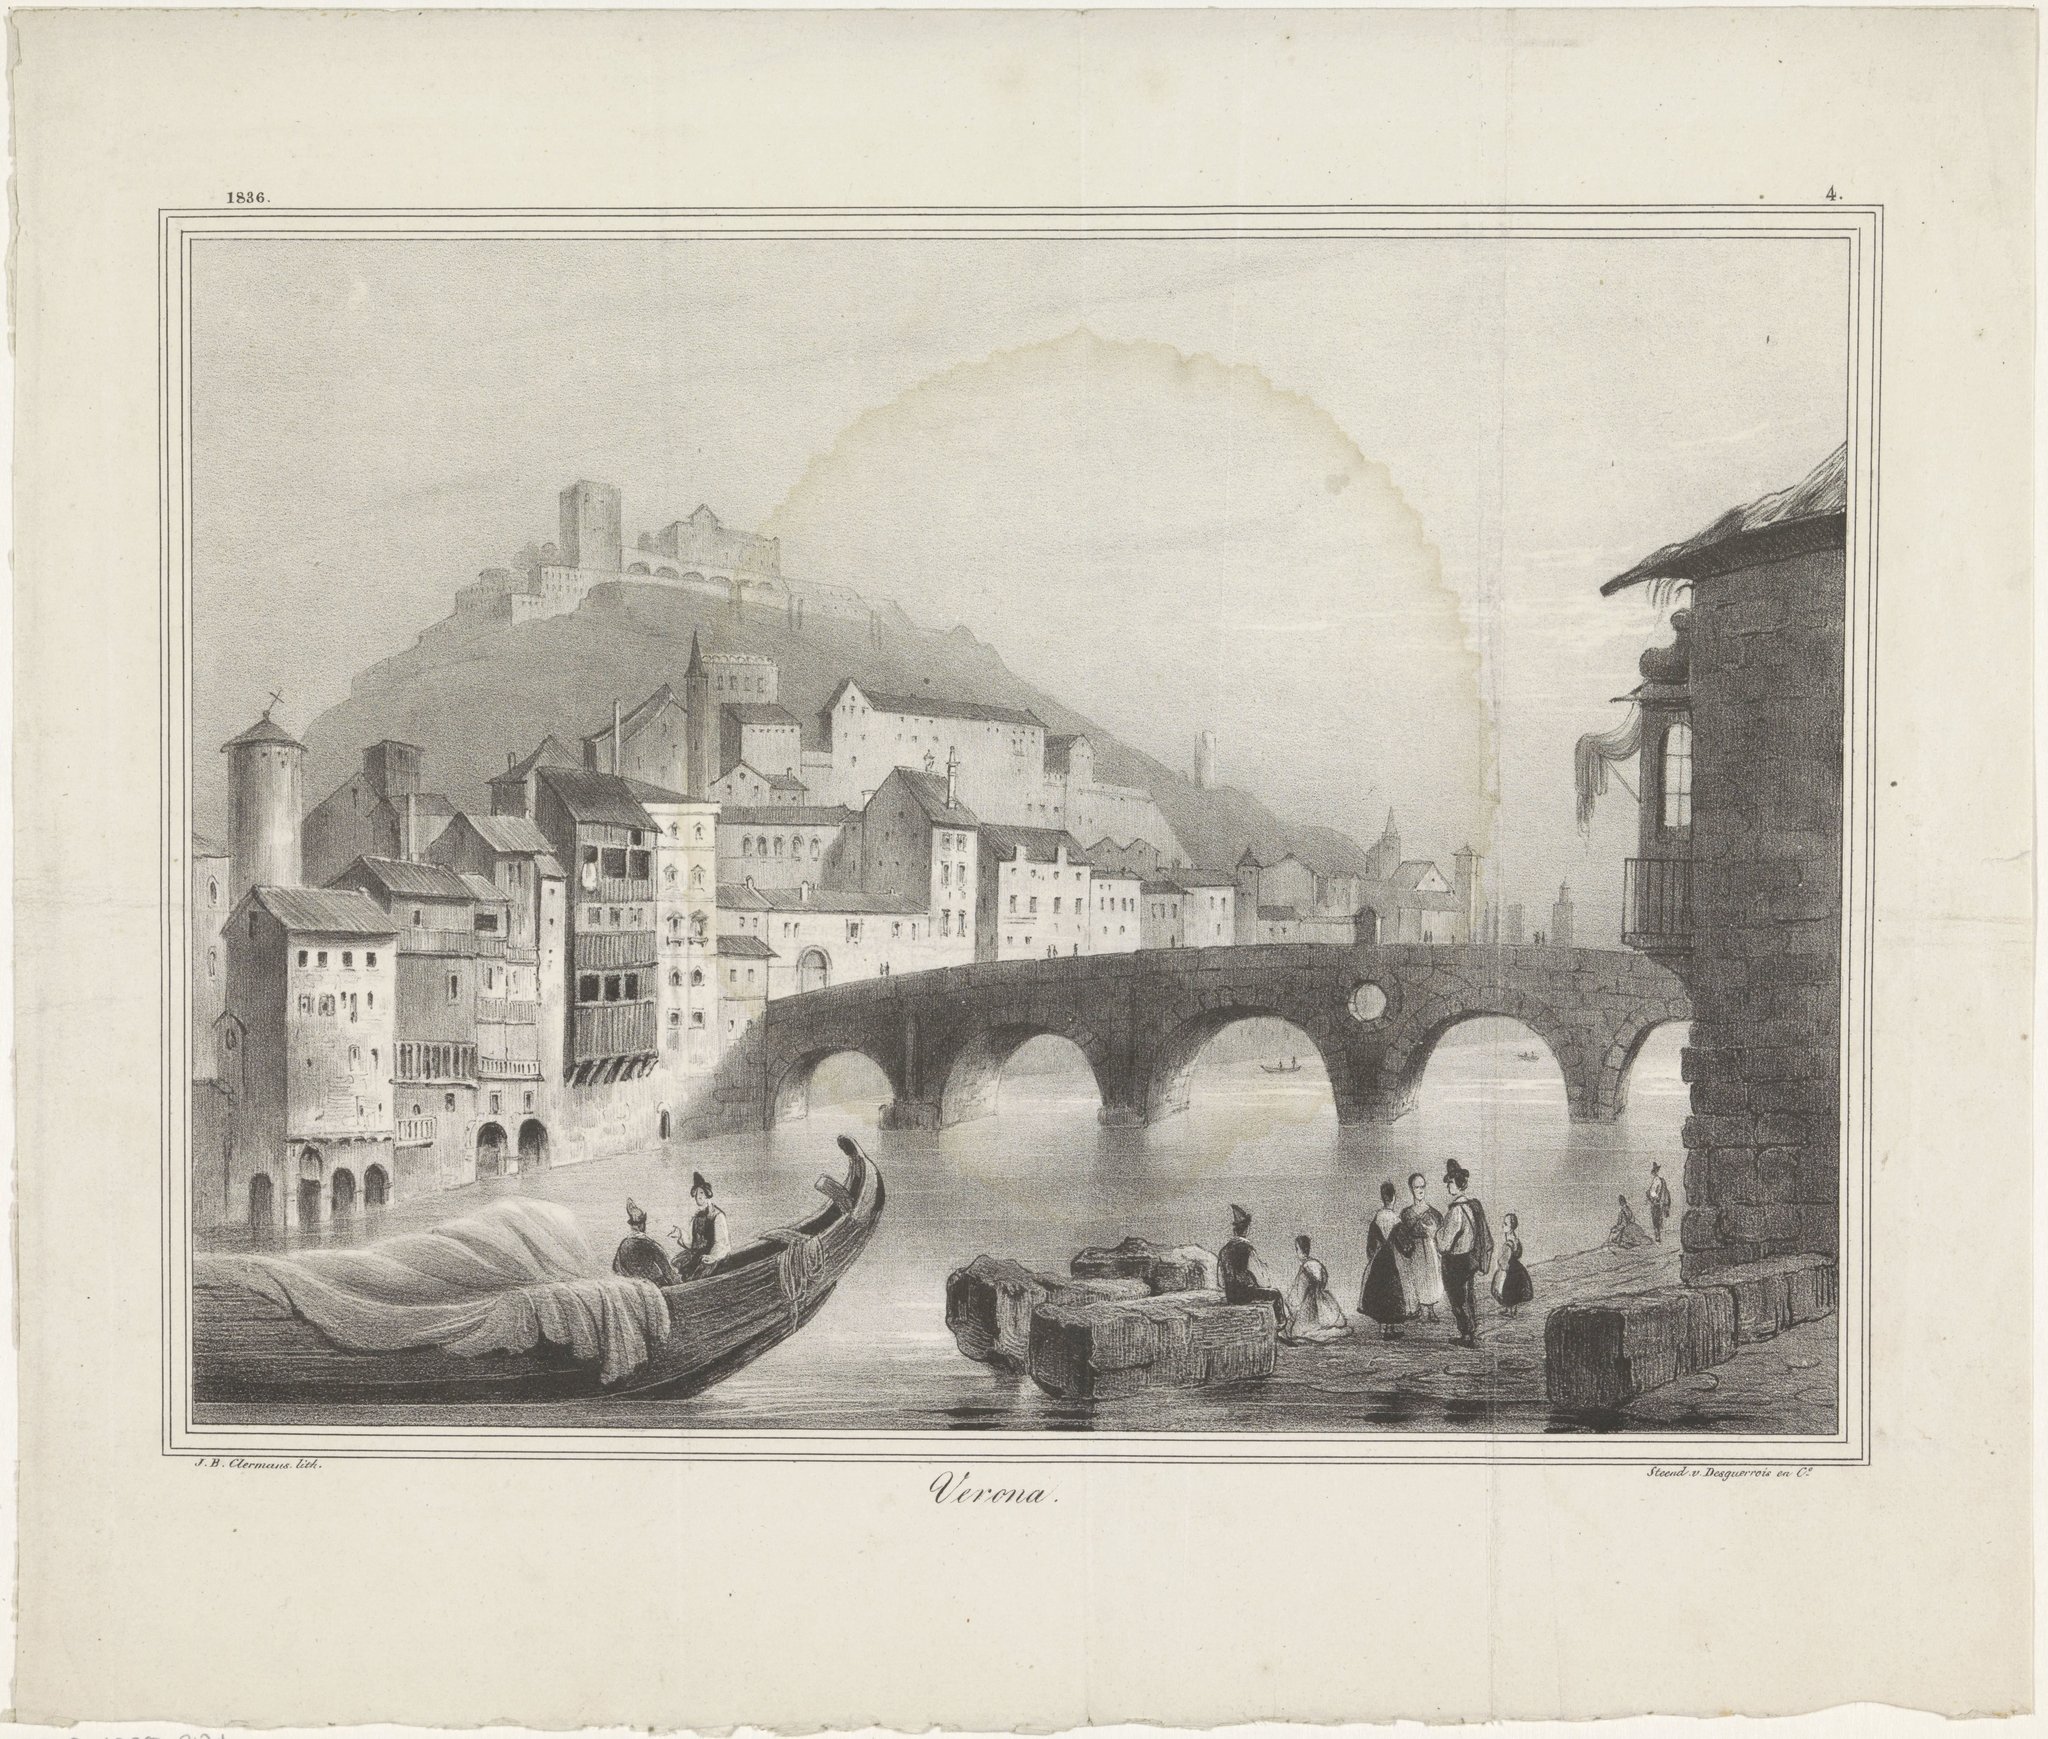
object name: print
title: Gezicht op de Ponte Pietra in Verona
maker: j.b. clermans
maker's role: print maker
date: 1826-1839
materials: paper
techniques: lithograph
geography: amsterdam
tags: landscape with bridge, viaduct or aqueduct, landscape with tower or castle (+ city(-scape) with figures, staffage)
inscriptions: collector's mark: Lugt 2228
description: Op de rivier de Adige ligt, half zichtbaar, een boot met twee figuren en een groot zeil. Op de oever staan en zitten figuren. Links op de heuvel ligt Castel San Pietro.